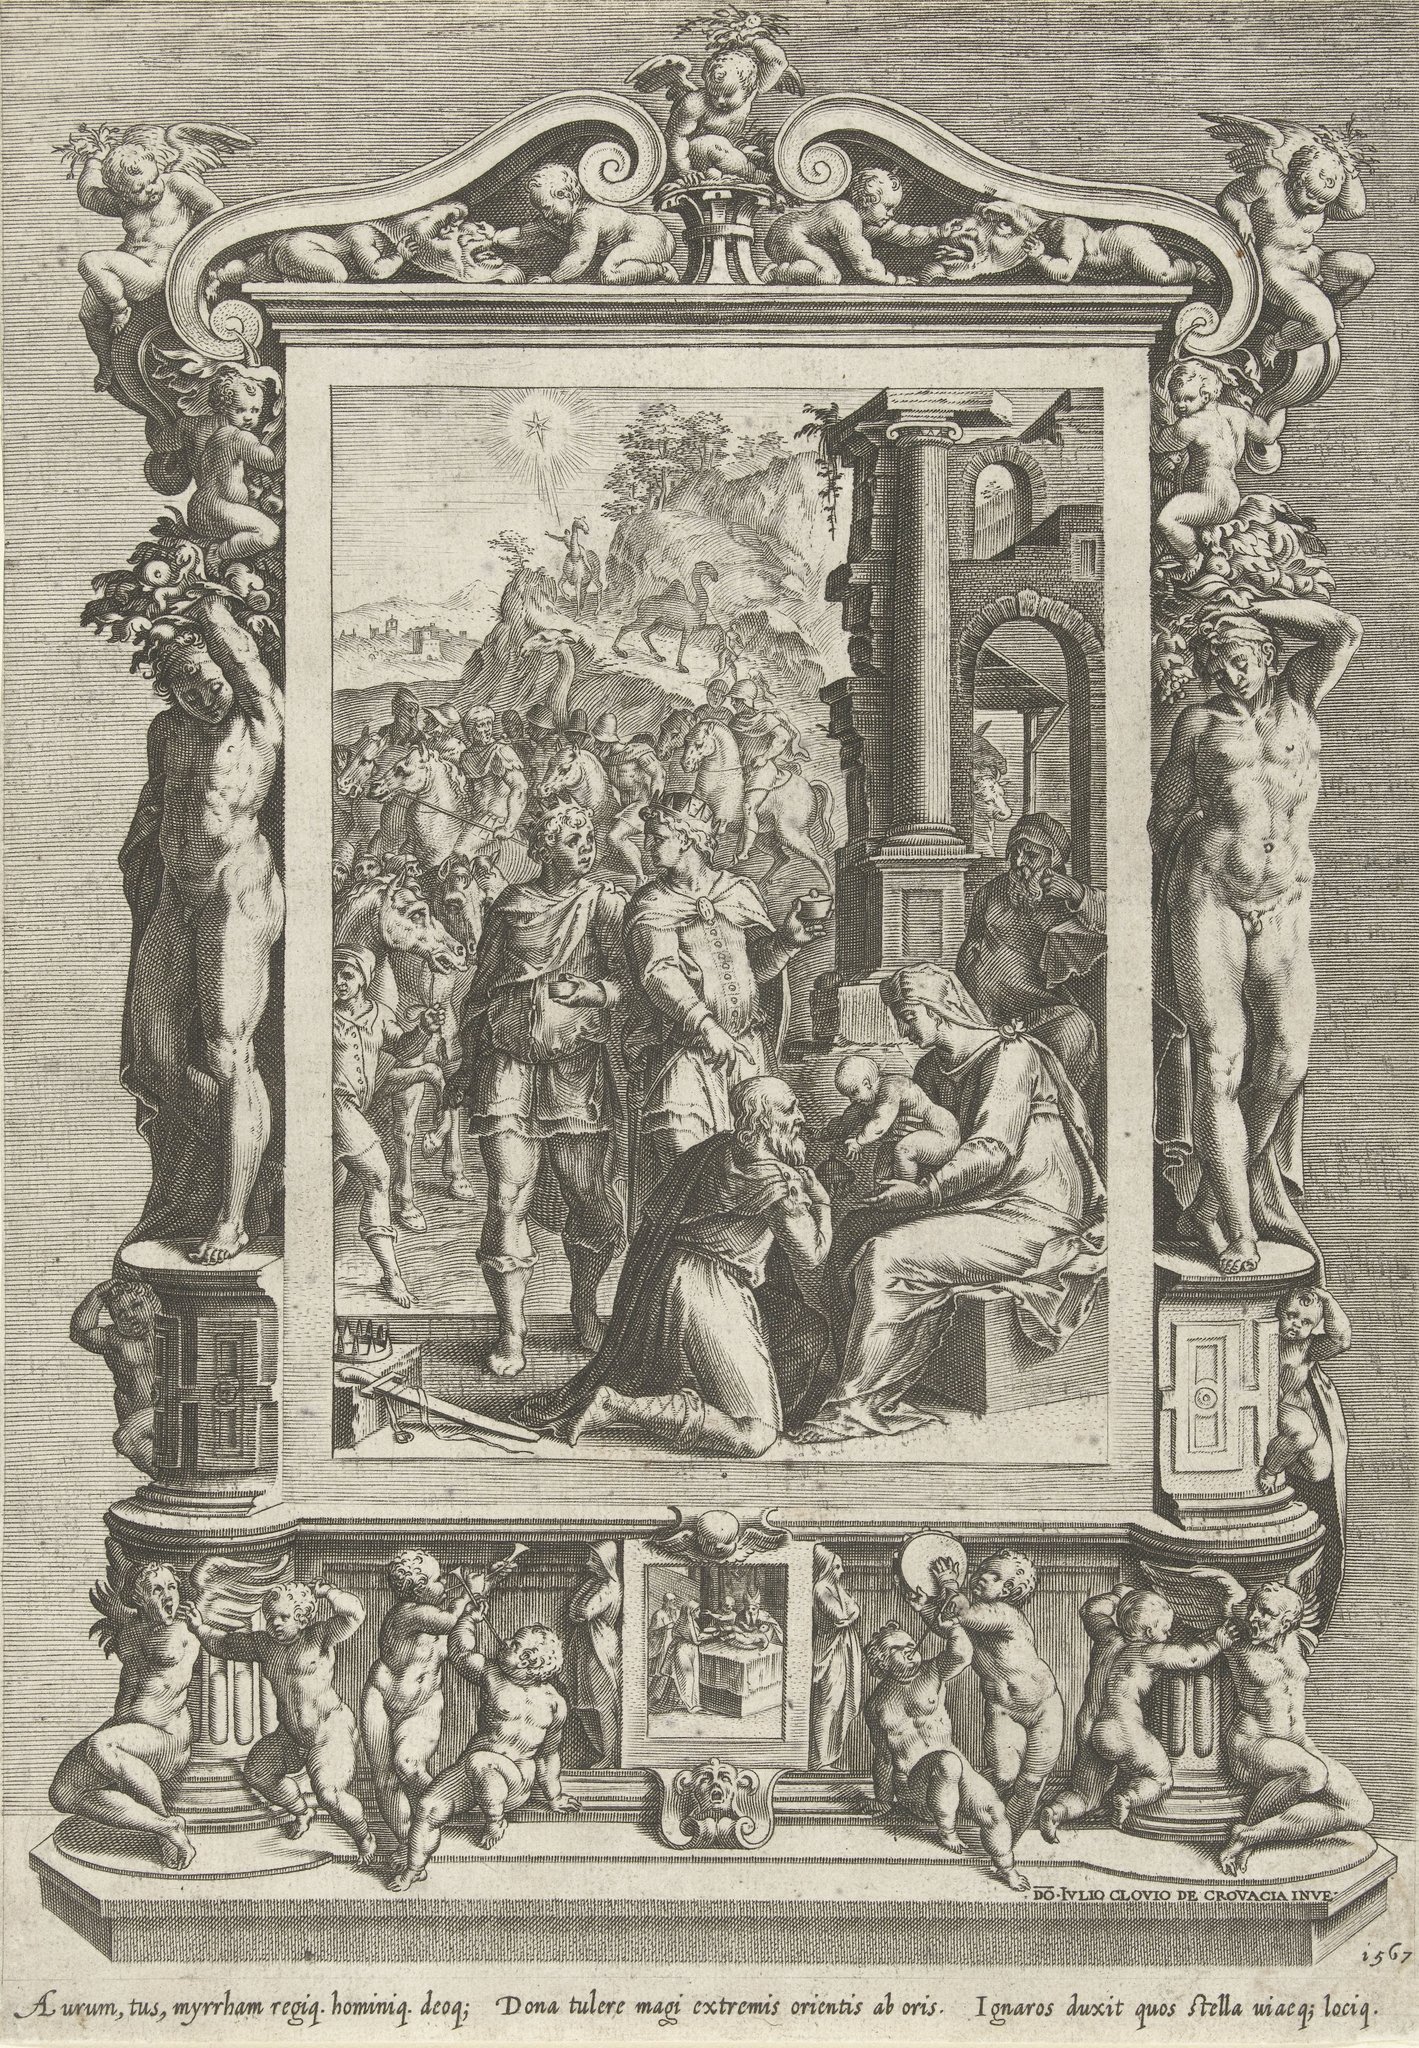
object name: print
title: Aanbidding door de koningen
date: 1567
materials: paper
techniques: engraving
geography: rome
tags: angels singing, making music, adoration of the kings: the wise men present their gifts to the christ-child (gold, frankincense and myrrh), ornament derived from architectural details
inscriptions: signature: ‘DO[N] JULIO CLOVIO DE CROVACIA INVE’, caption: ‘Aurum, tus, myrrham regiq. hominiq. deocq; // Dona tulere magi extremis orientis ab oris. // Ignaros duxit quos stella viaeq; lociq.’, collector's mark: Lugt 240, date: ‘1567’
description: Aanbidding door de koningen in architecturale omlijsting met putti en musicerende engelen. Rechts Jozef en Maria met het Kind op schoot voor een antiek gebouw. De drie koningen bieden geschenken aan. De voorste koning zit geknield, de twee anderen staan. Achter hen een stoet met ruiters en kamelen. In de omlijsting een plaquette met de presentatie van Christus in de tempel.